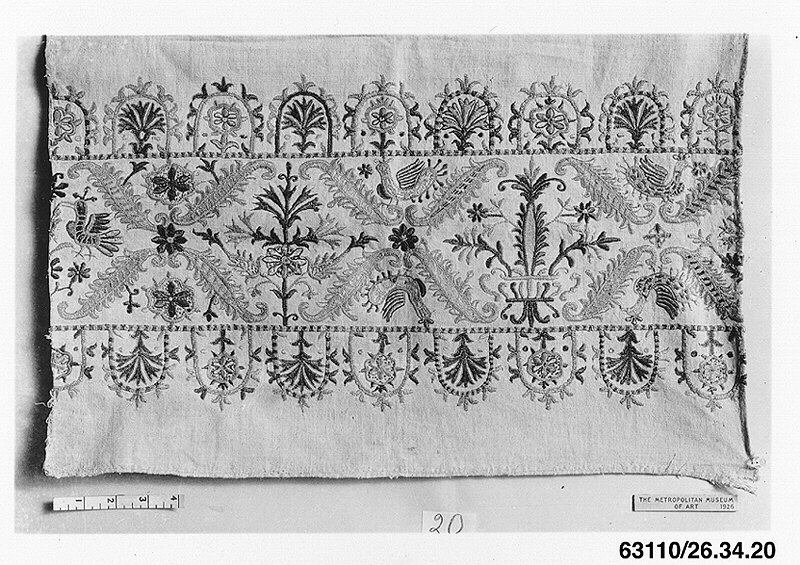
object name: border fragment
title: Portion of a dress border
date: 1701-1800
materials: linen